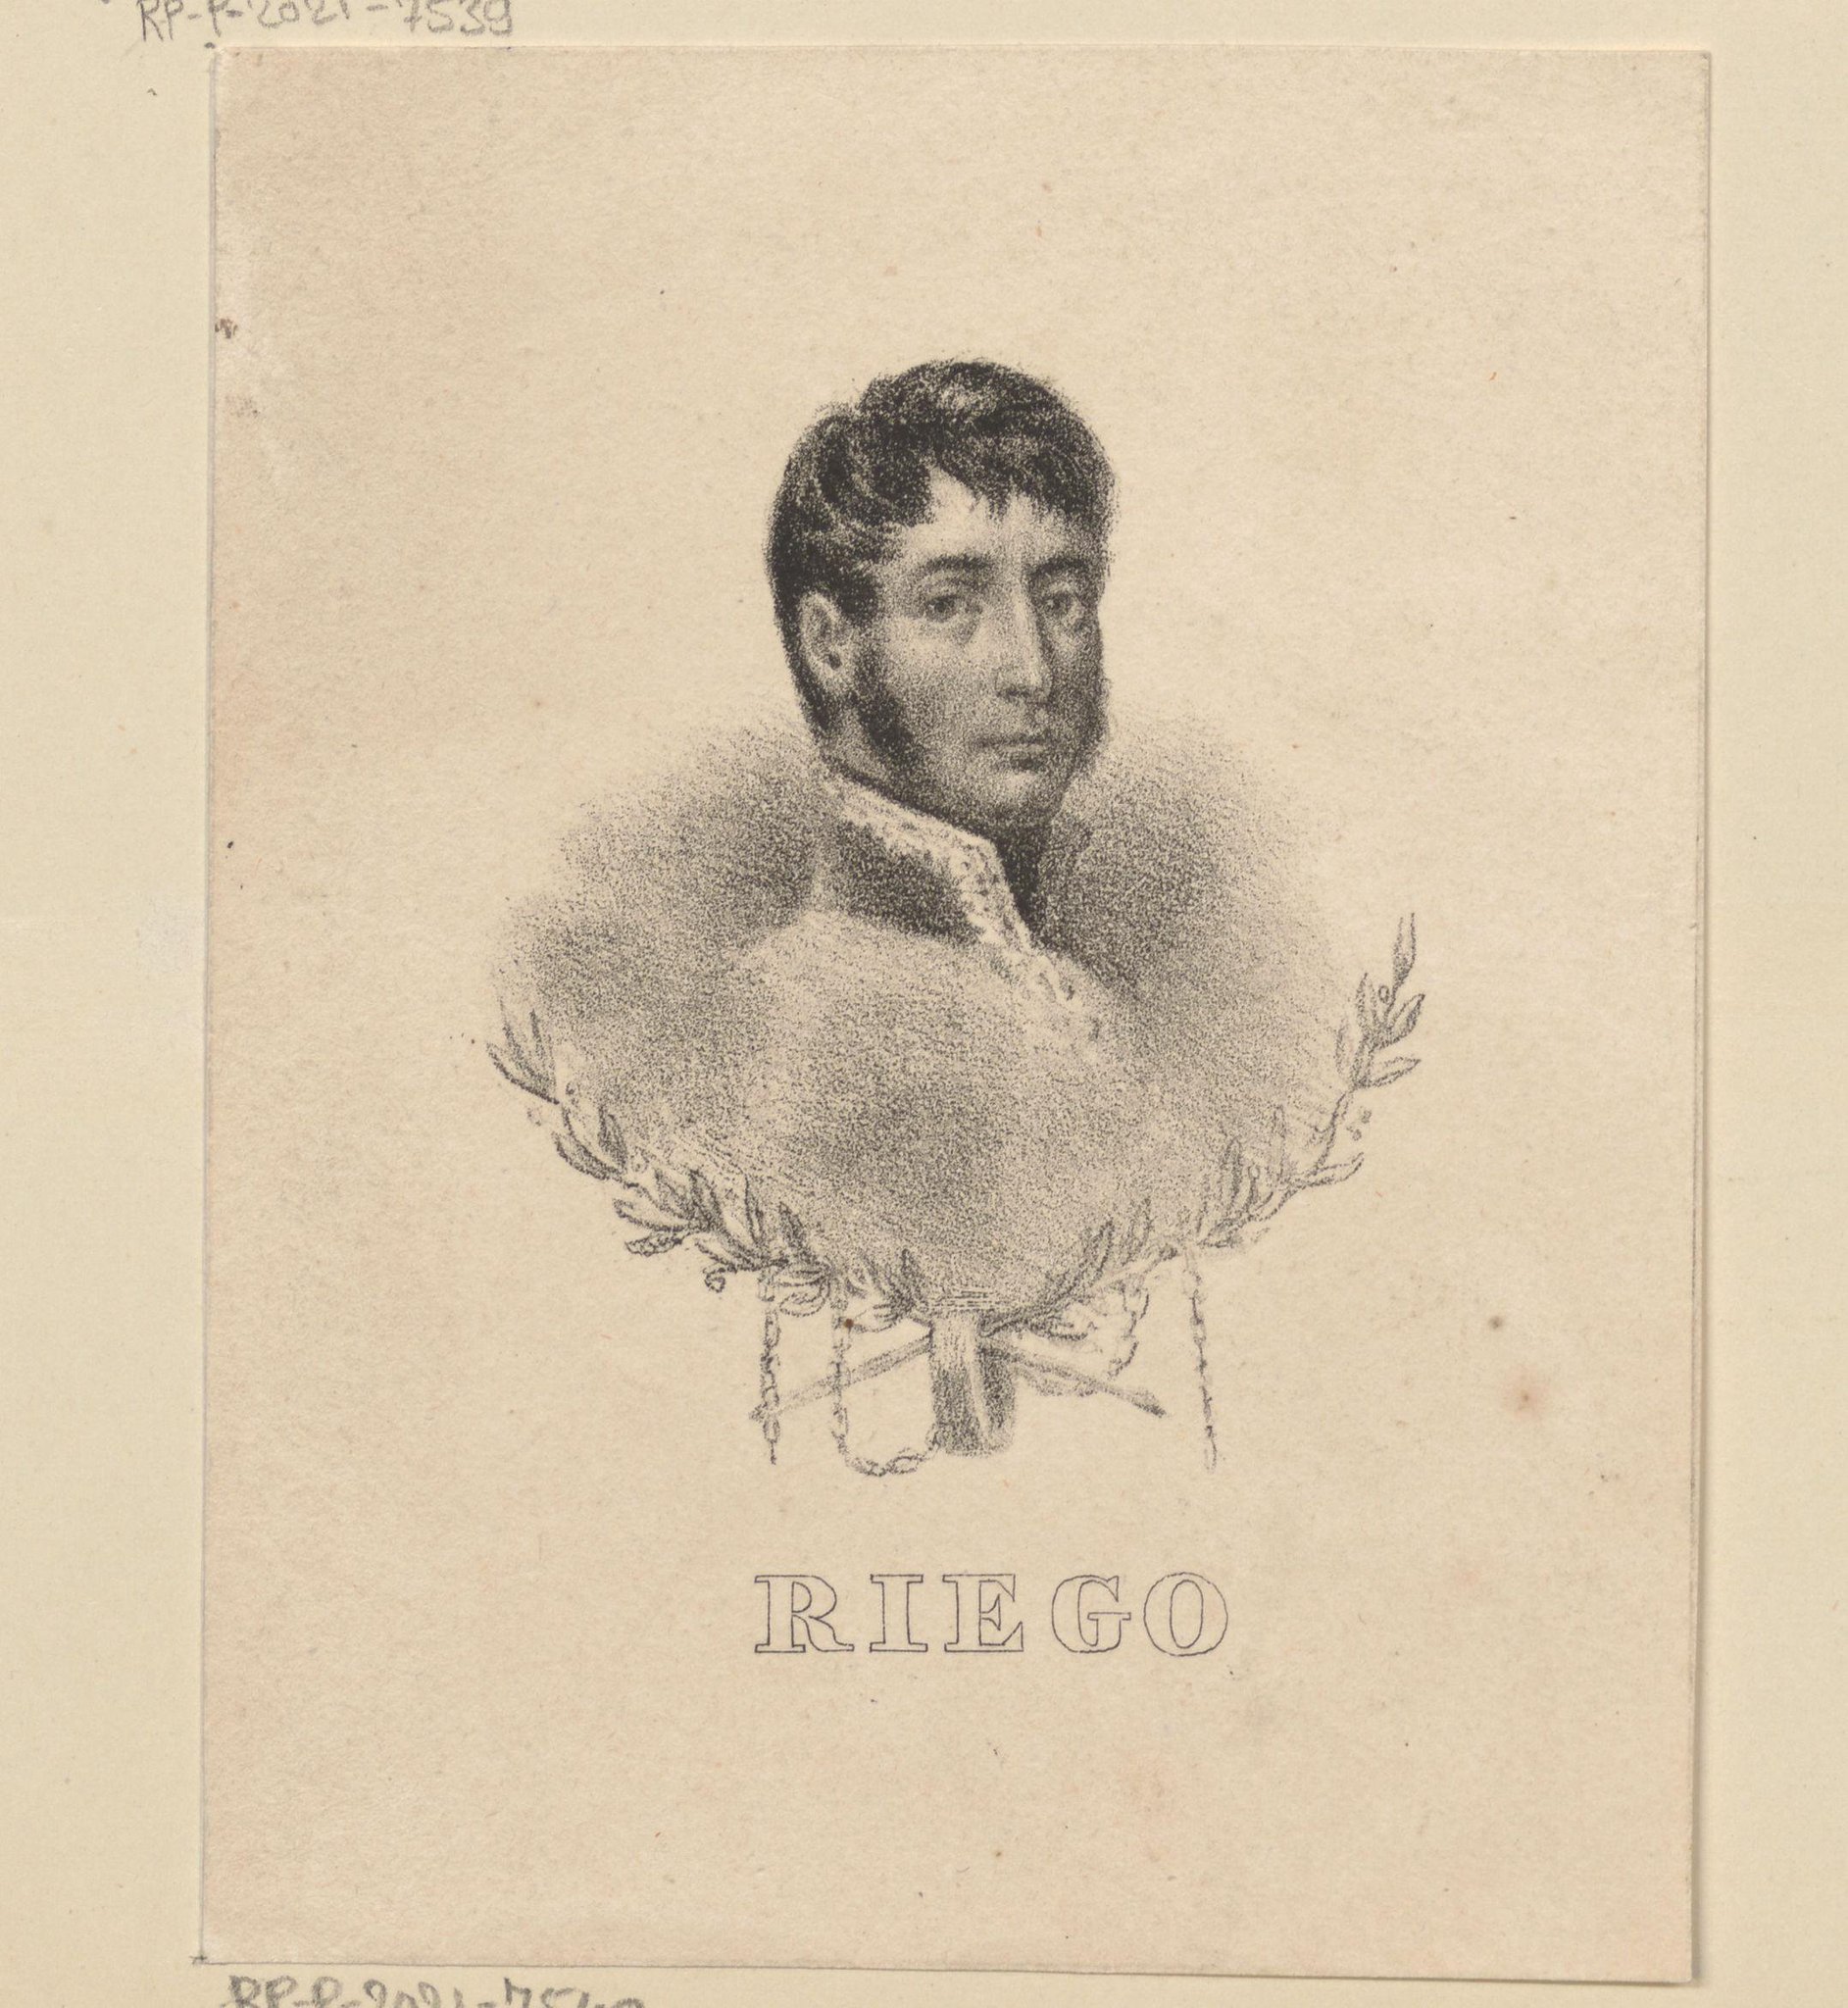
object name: print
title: Portret van Rafael del Riego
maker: Anonymous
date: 1795-1849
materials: paper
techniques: letterpress printing, lithograph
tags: politician, historical persons